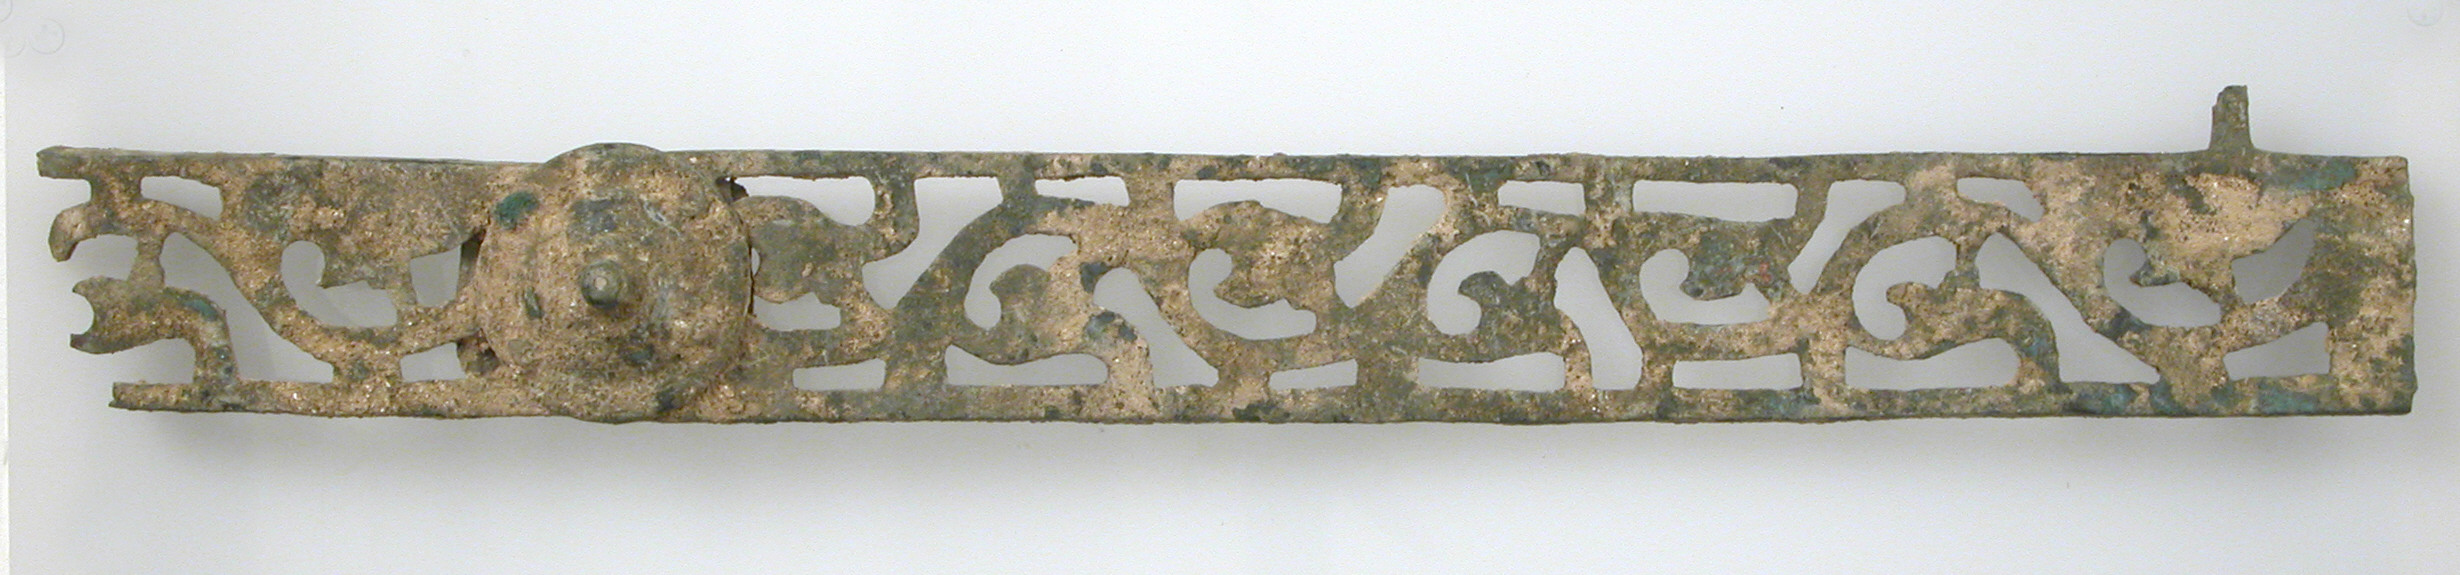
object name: railing fragment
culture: byzantine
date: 401-500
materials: copper alloy